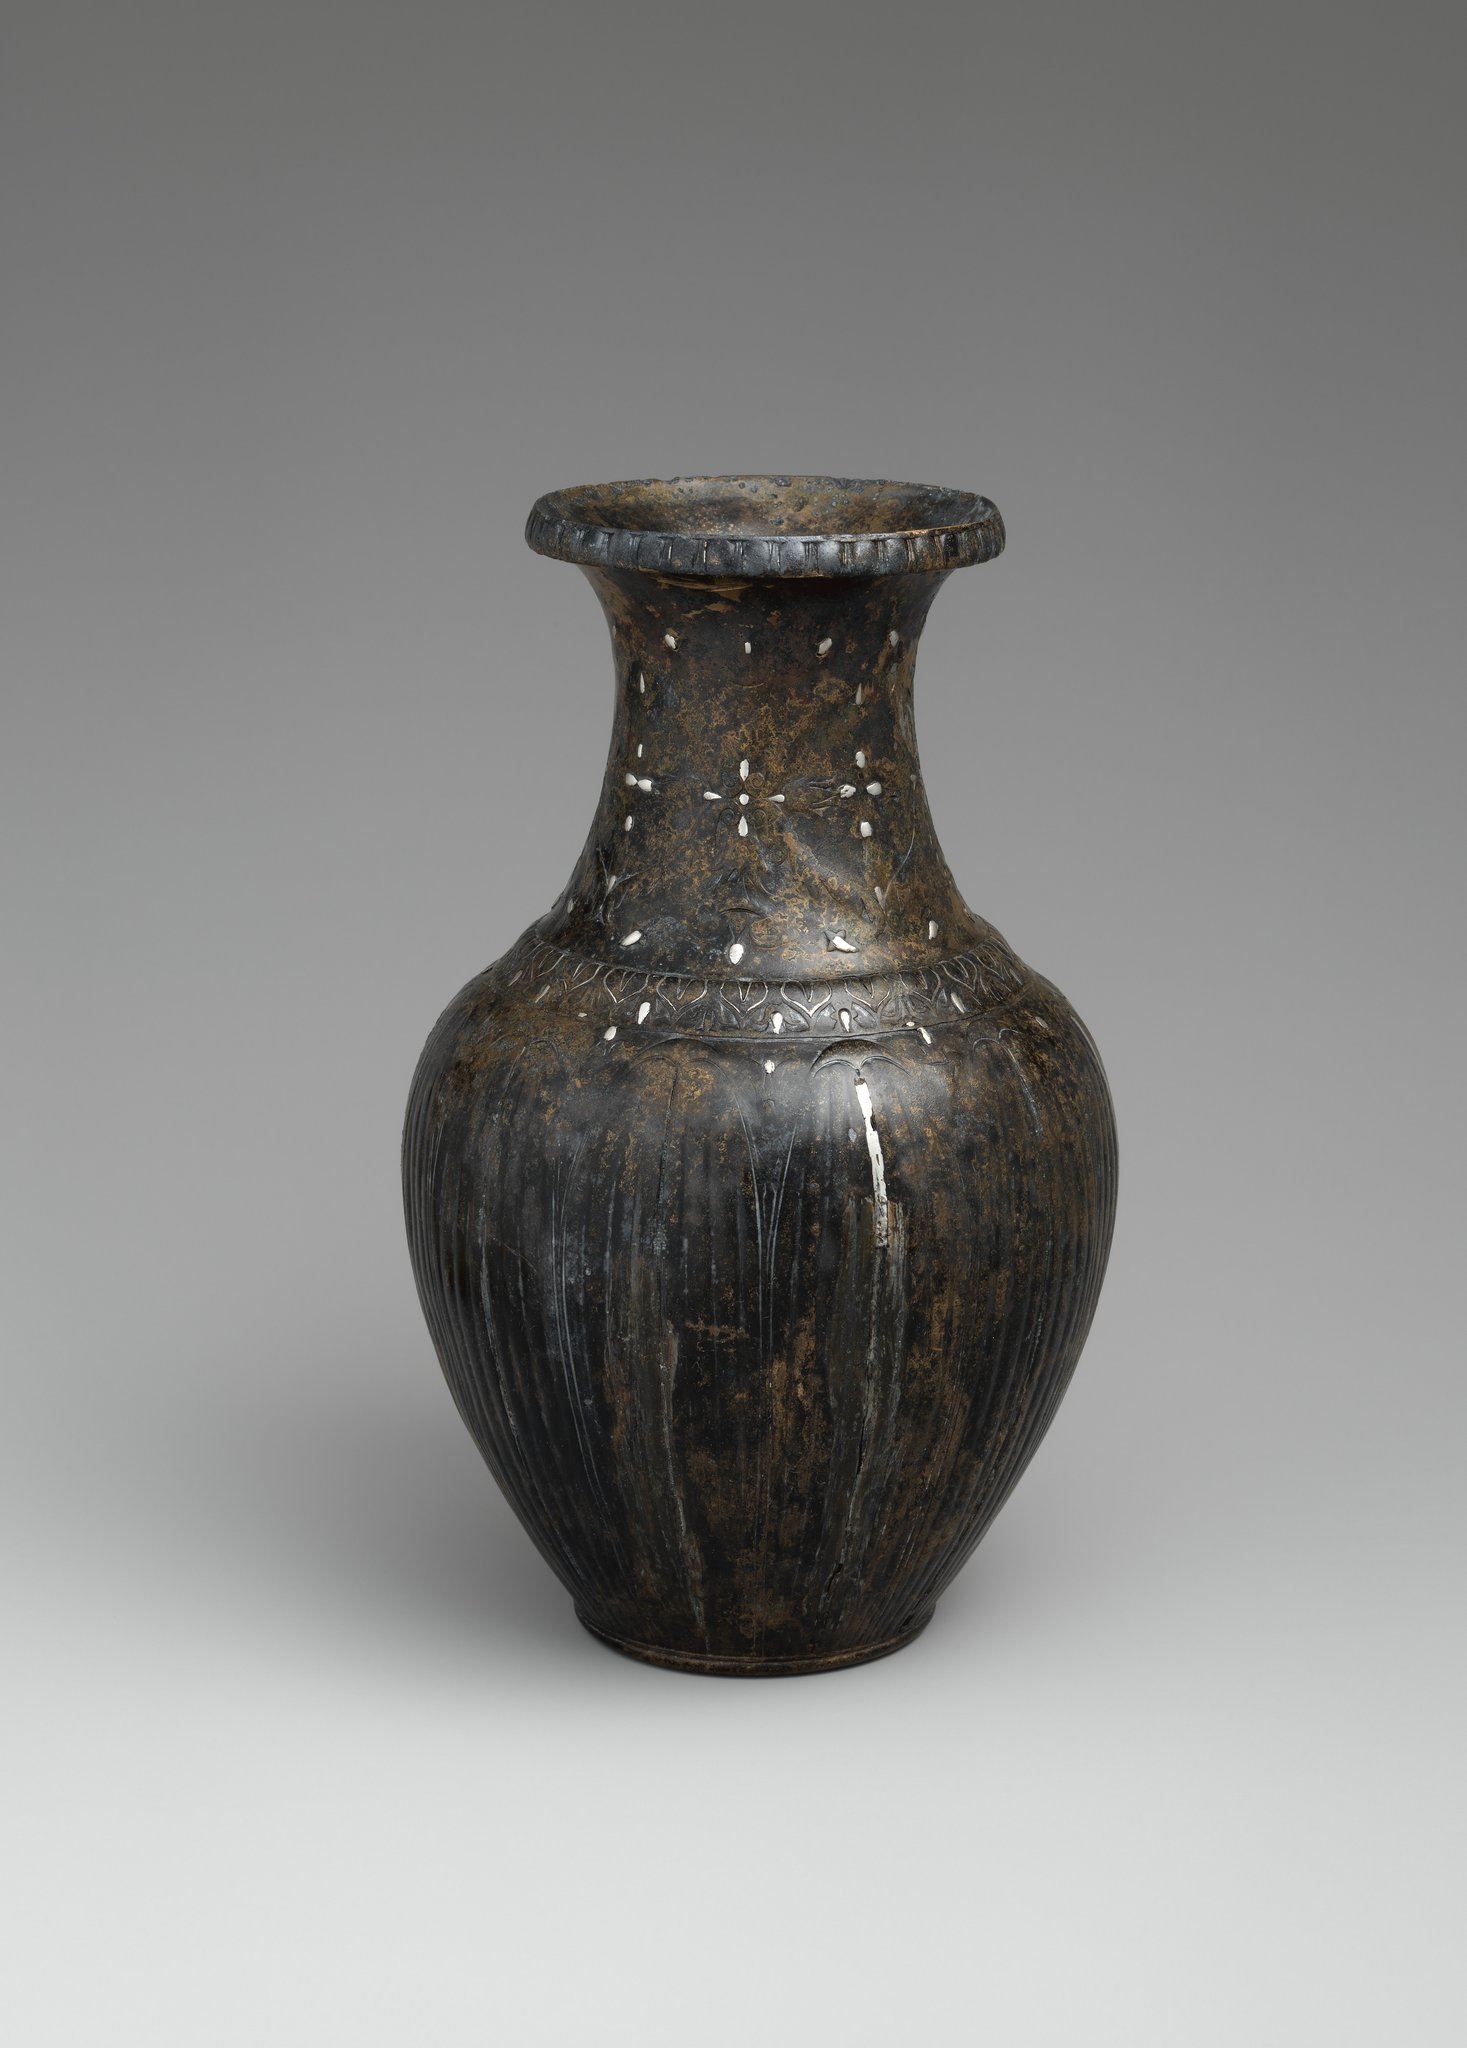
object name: vessel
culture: parthian or seleucid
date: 201-300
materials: bronze, silver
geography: iran